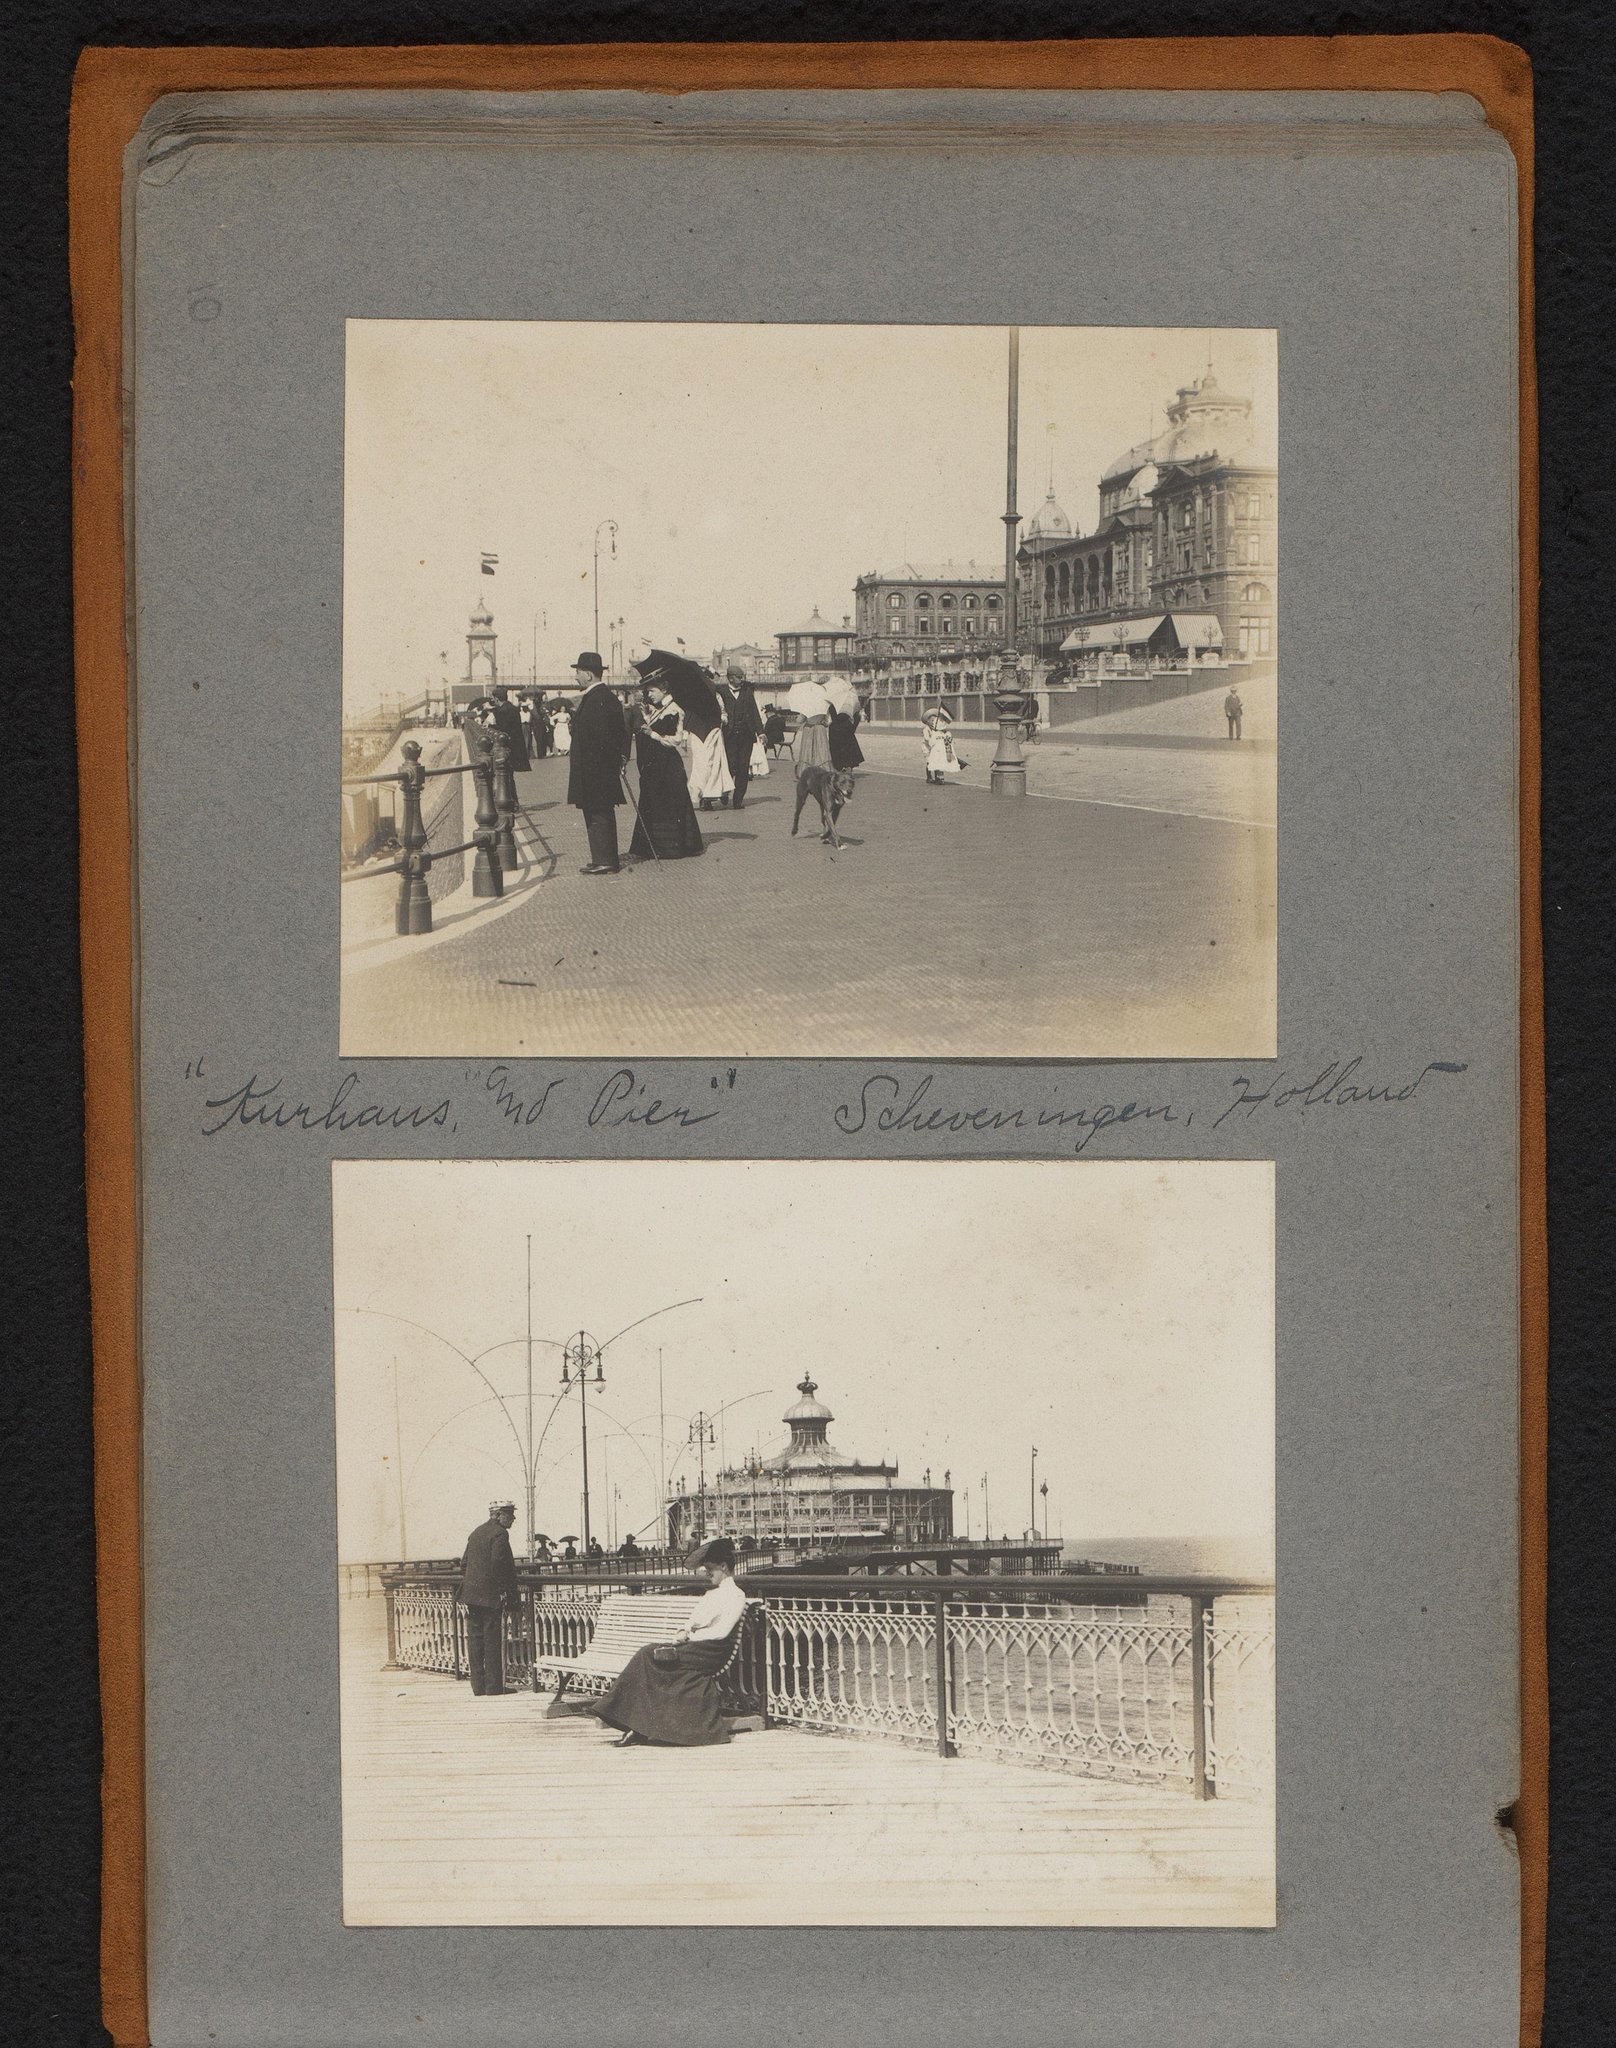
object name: album leaf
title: Kurhaus en pier Scheveningen, Holland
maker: jan van der mey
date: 1902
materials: paper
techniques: gelatin silver print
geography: scheveningen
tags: pier, quay, wharf, quay, historical persons not known by name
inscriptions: inscription: ‘"Kurhaus and Pier" Scheveningen, Holland’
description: Deze foto's maken deel uit van een album.